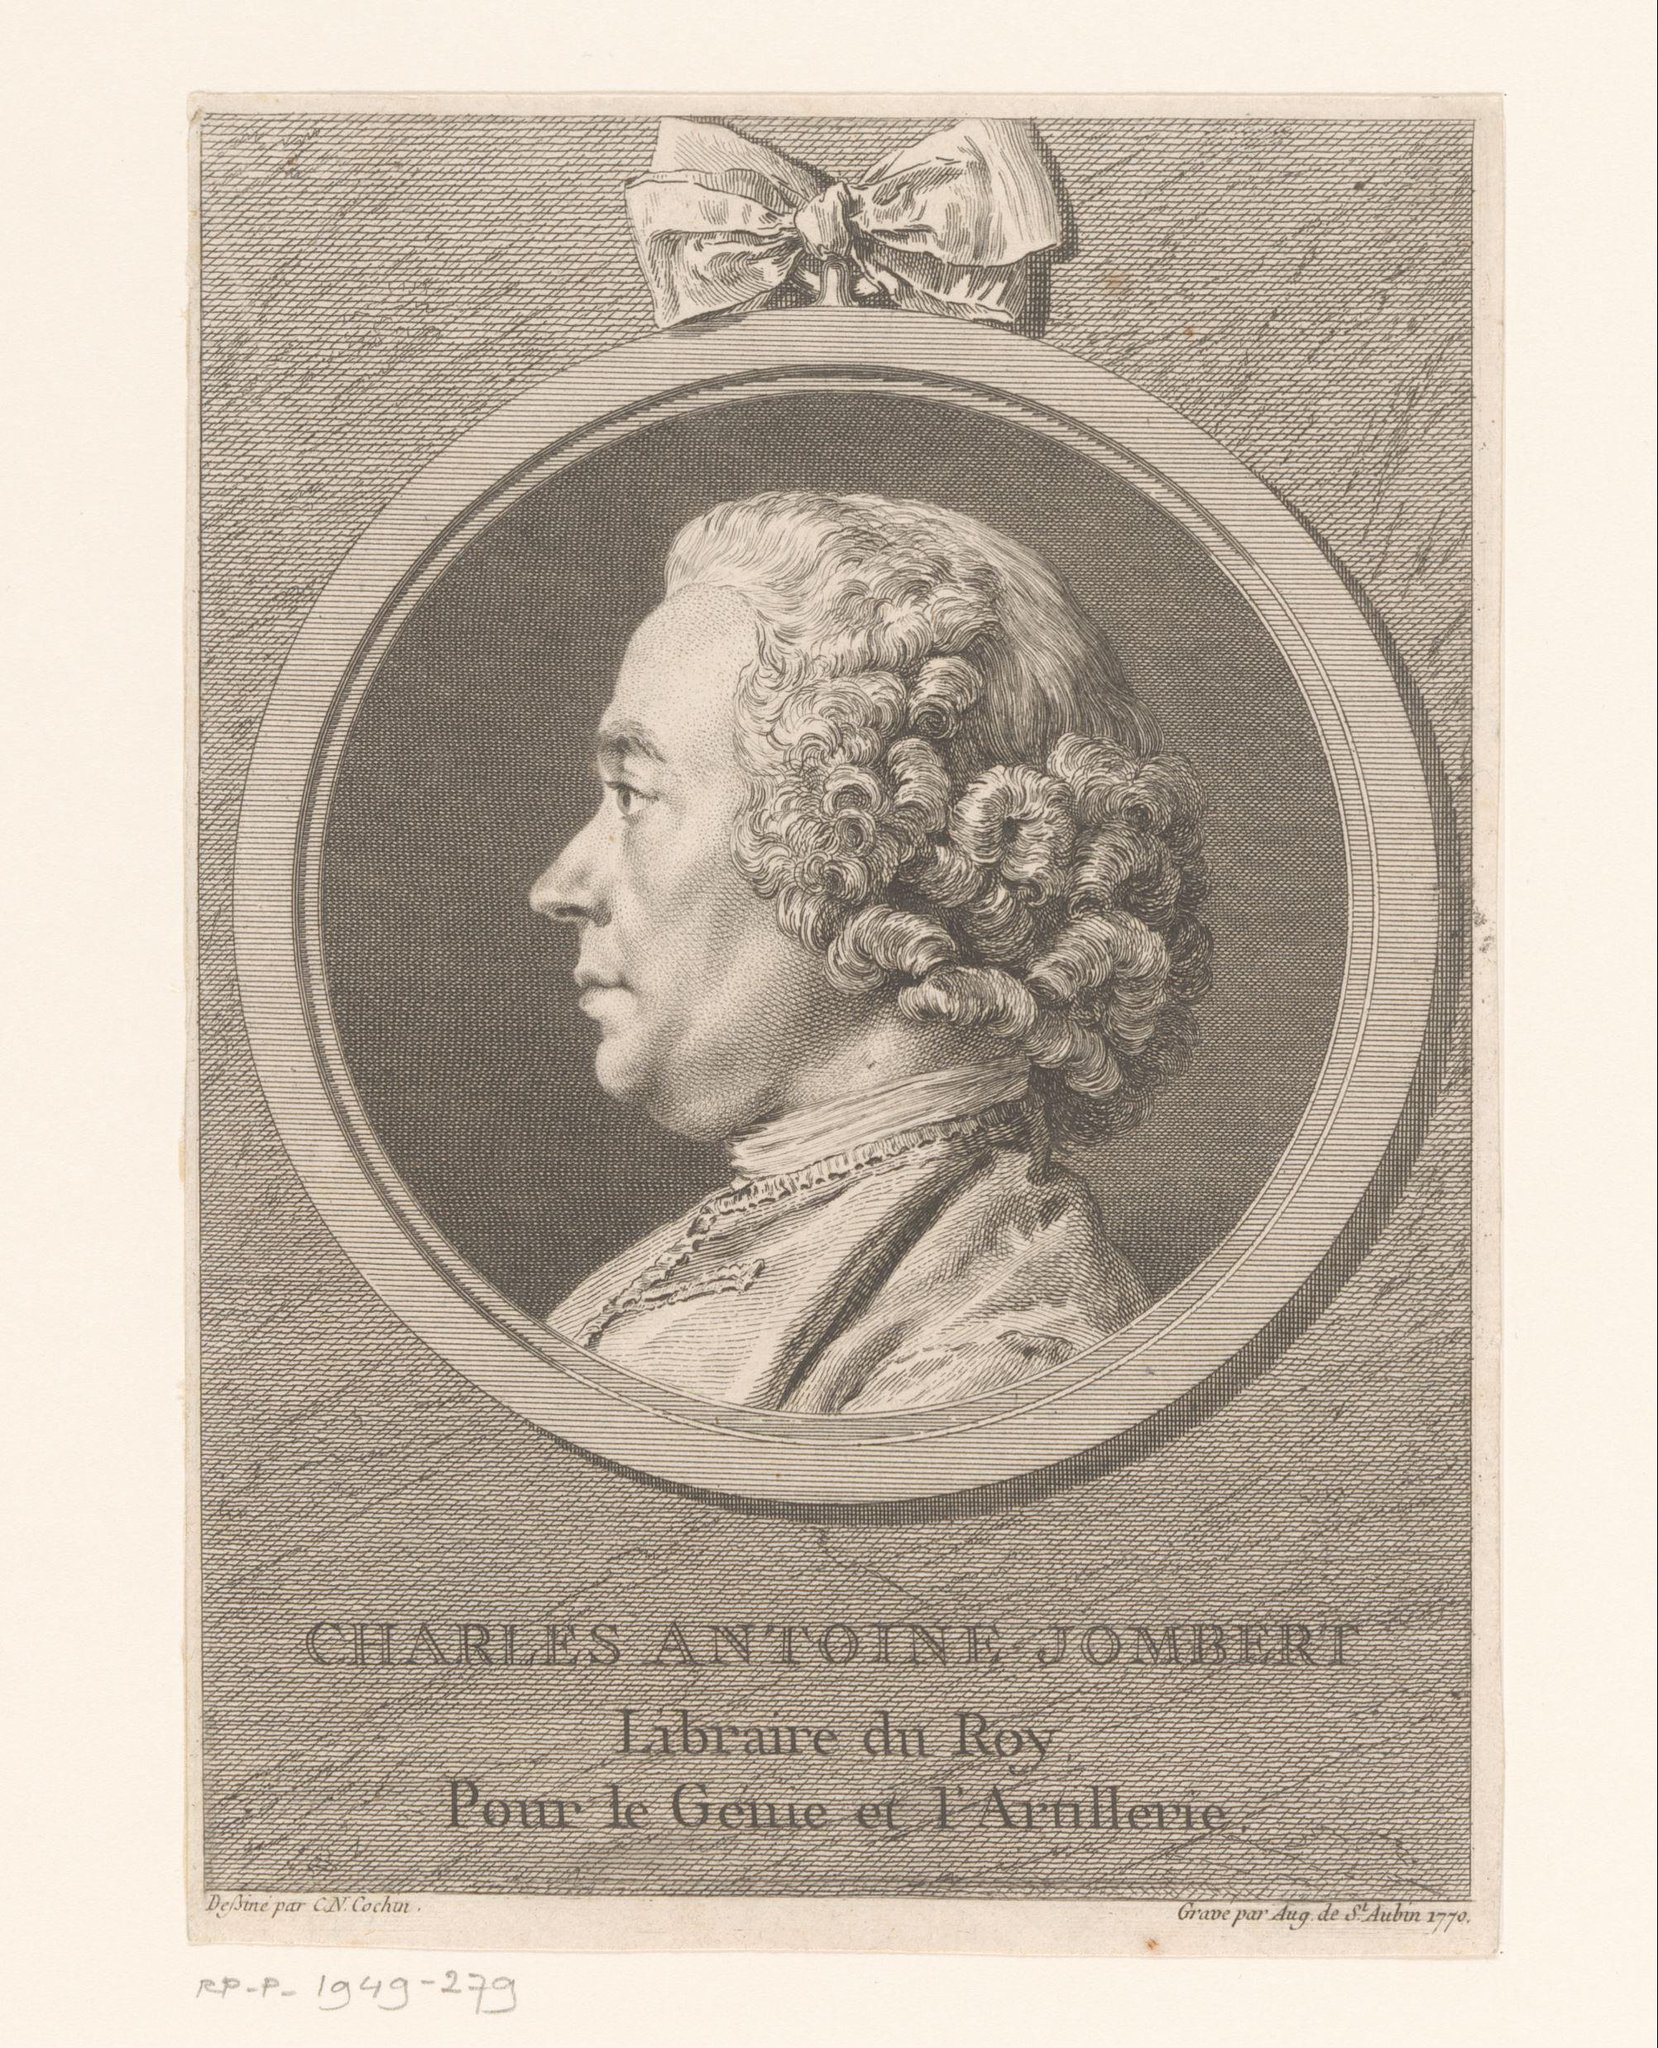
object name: print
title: Portret van Charles-Antoine Jombert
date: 1770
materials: paper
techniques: engraving, etching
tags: publisher, charles-antoine jombert, publishing, publisher (+ portrait of scholar, scientist), historical persons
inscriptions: collector's mark: Lugt 4347, collector's mark: Lugt 2228